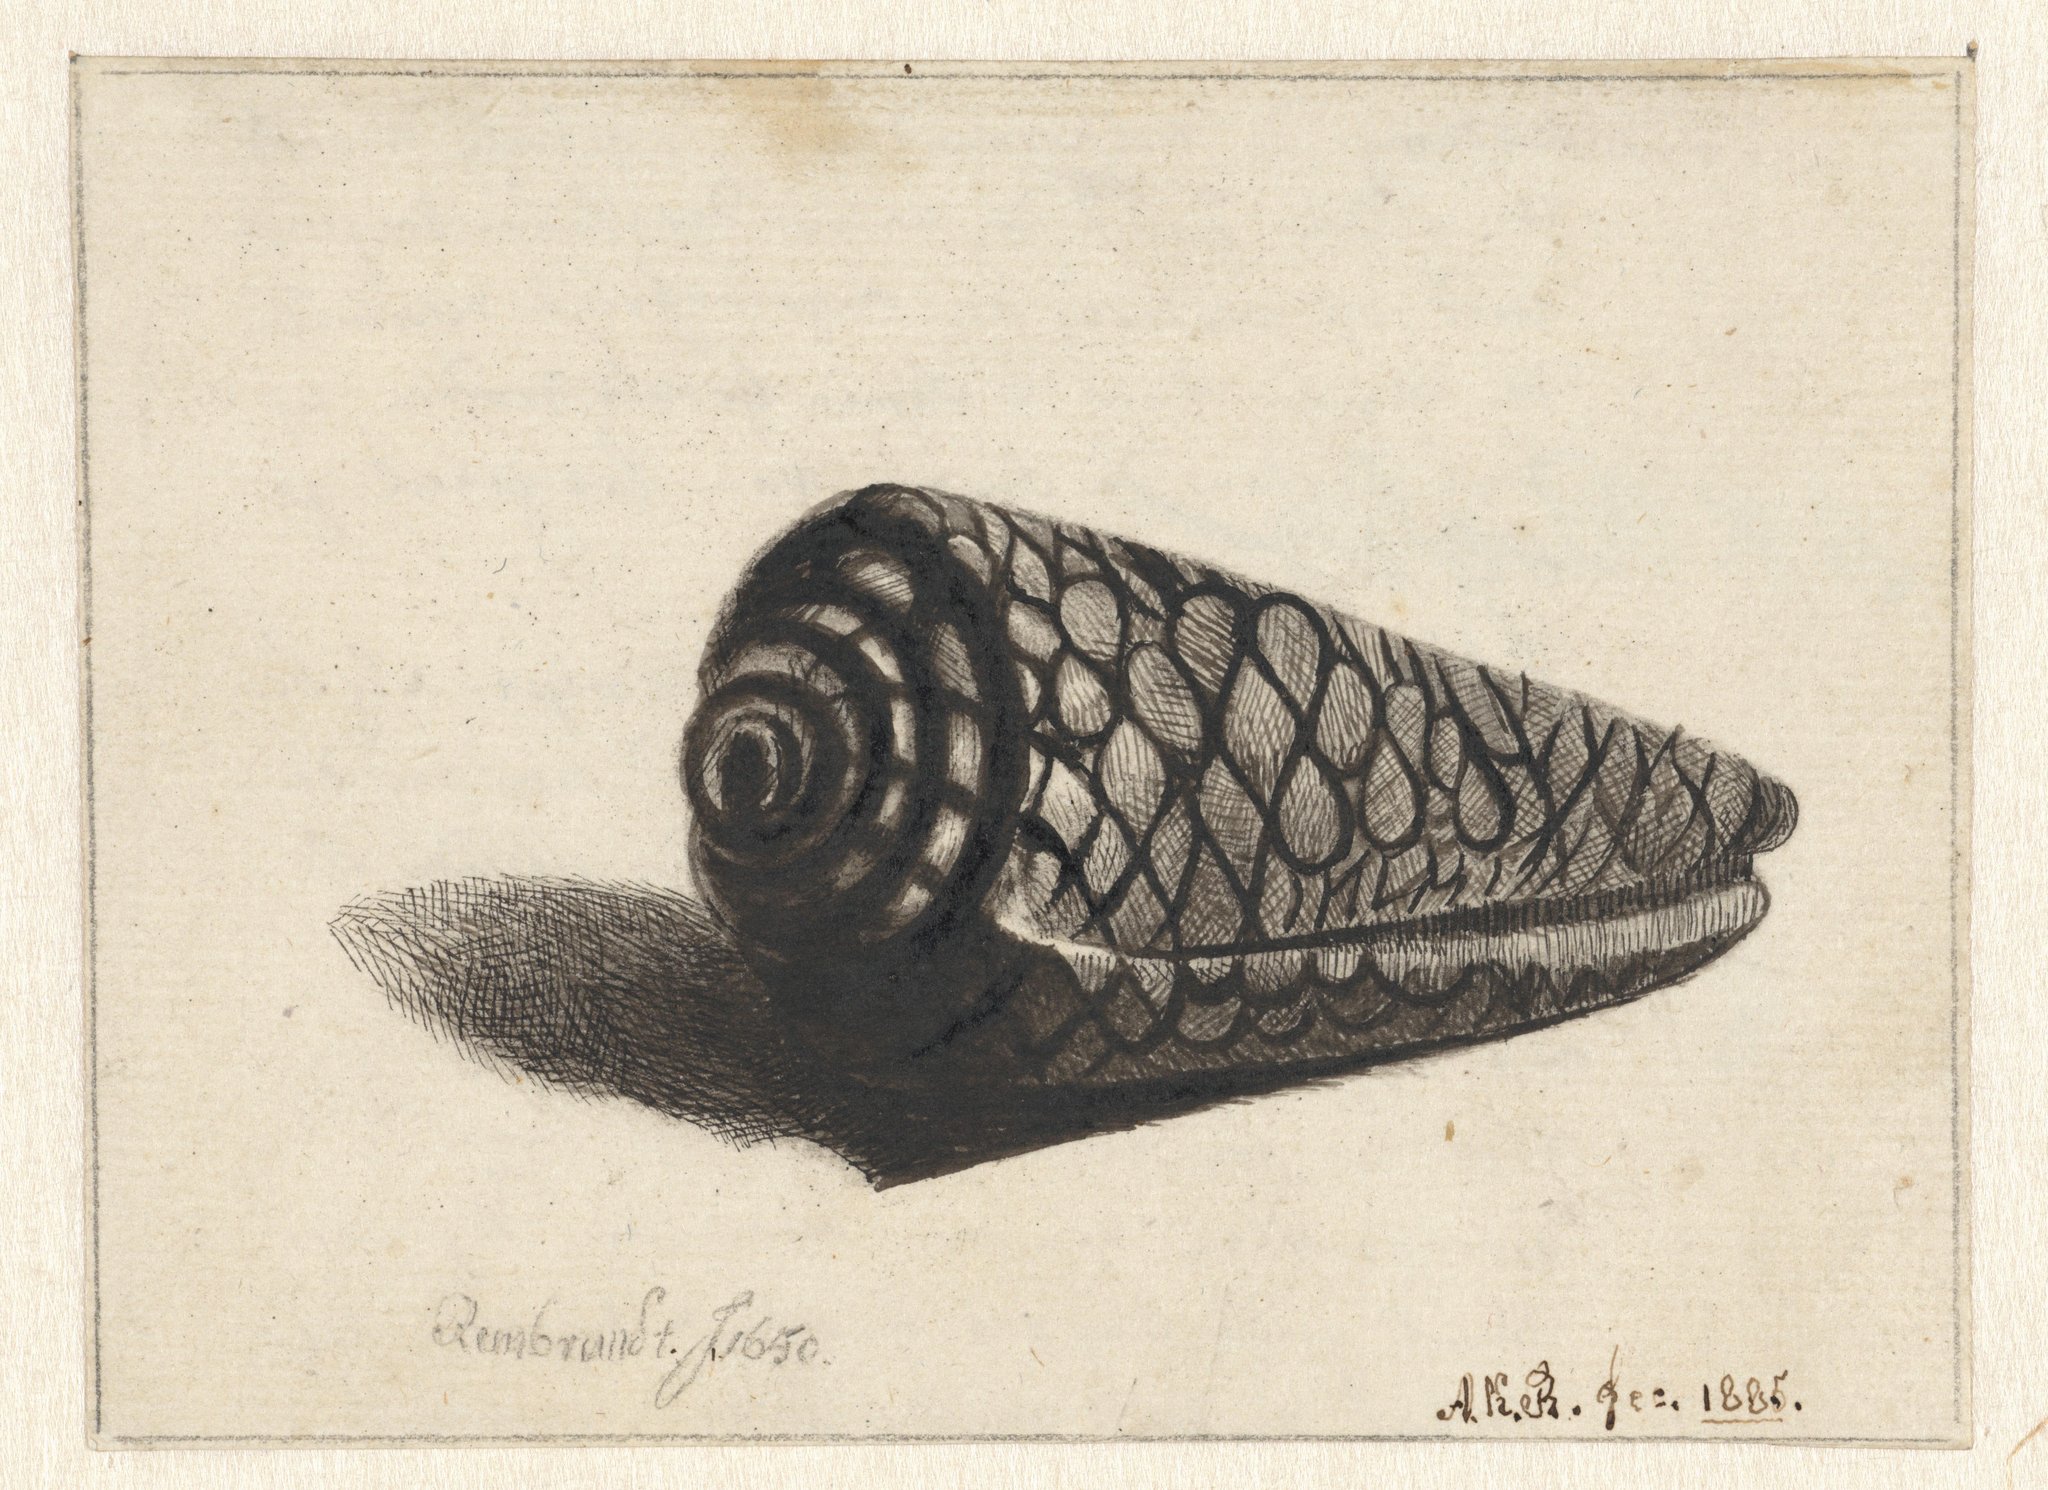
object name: drawing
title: Schelp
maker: anthonie karel ringler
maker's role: draughtsman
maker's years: 1817-1896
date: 1885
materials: ink, paper, pencil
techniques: brush, pen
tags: molluscs (+ shell, snail-shell etc.)